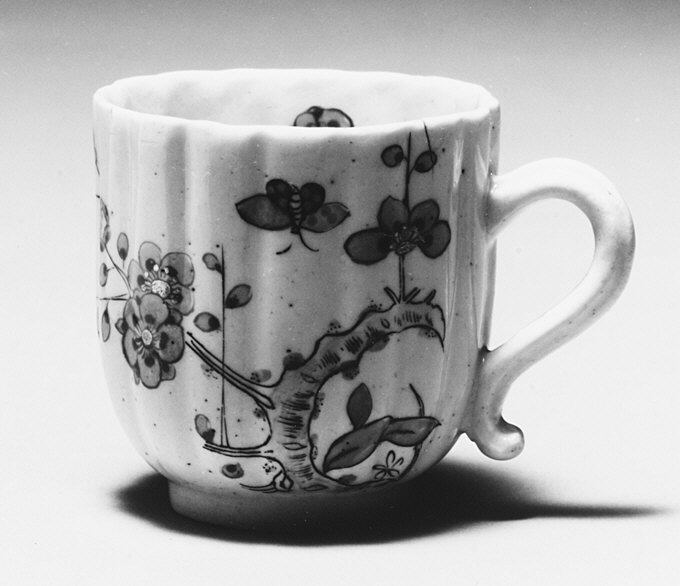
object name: cup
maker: derby porcelain manufactory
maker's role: factory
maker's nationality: british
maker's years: 1751-1785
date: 1755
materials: soft paste porcelain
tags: butterflies,flowers